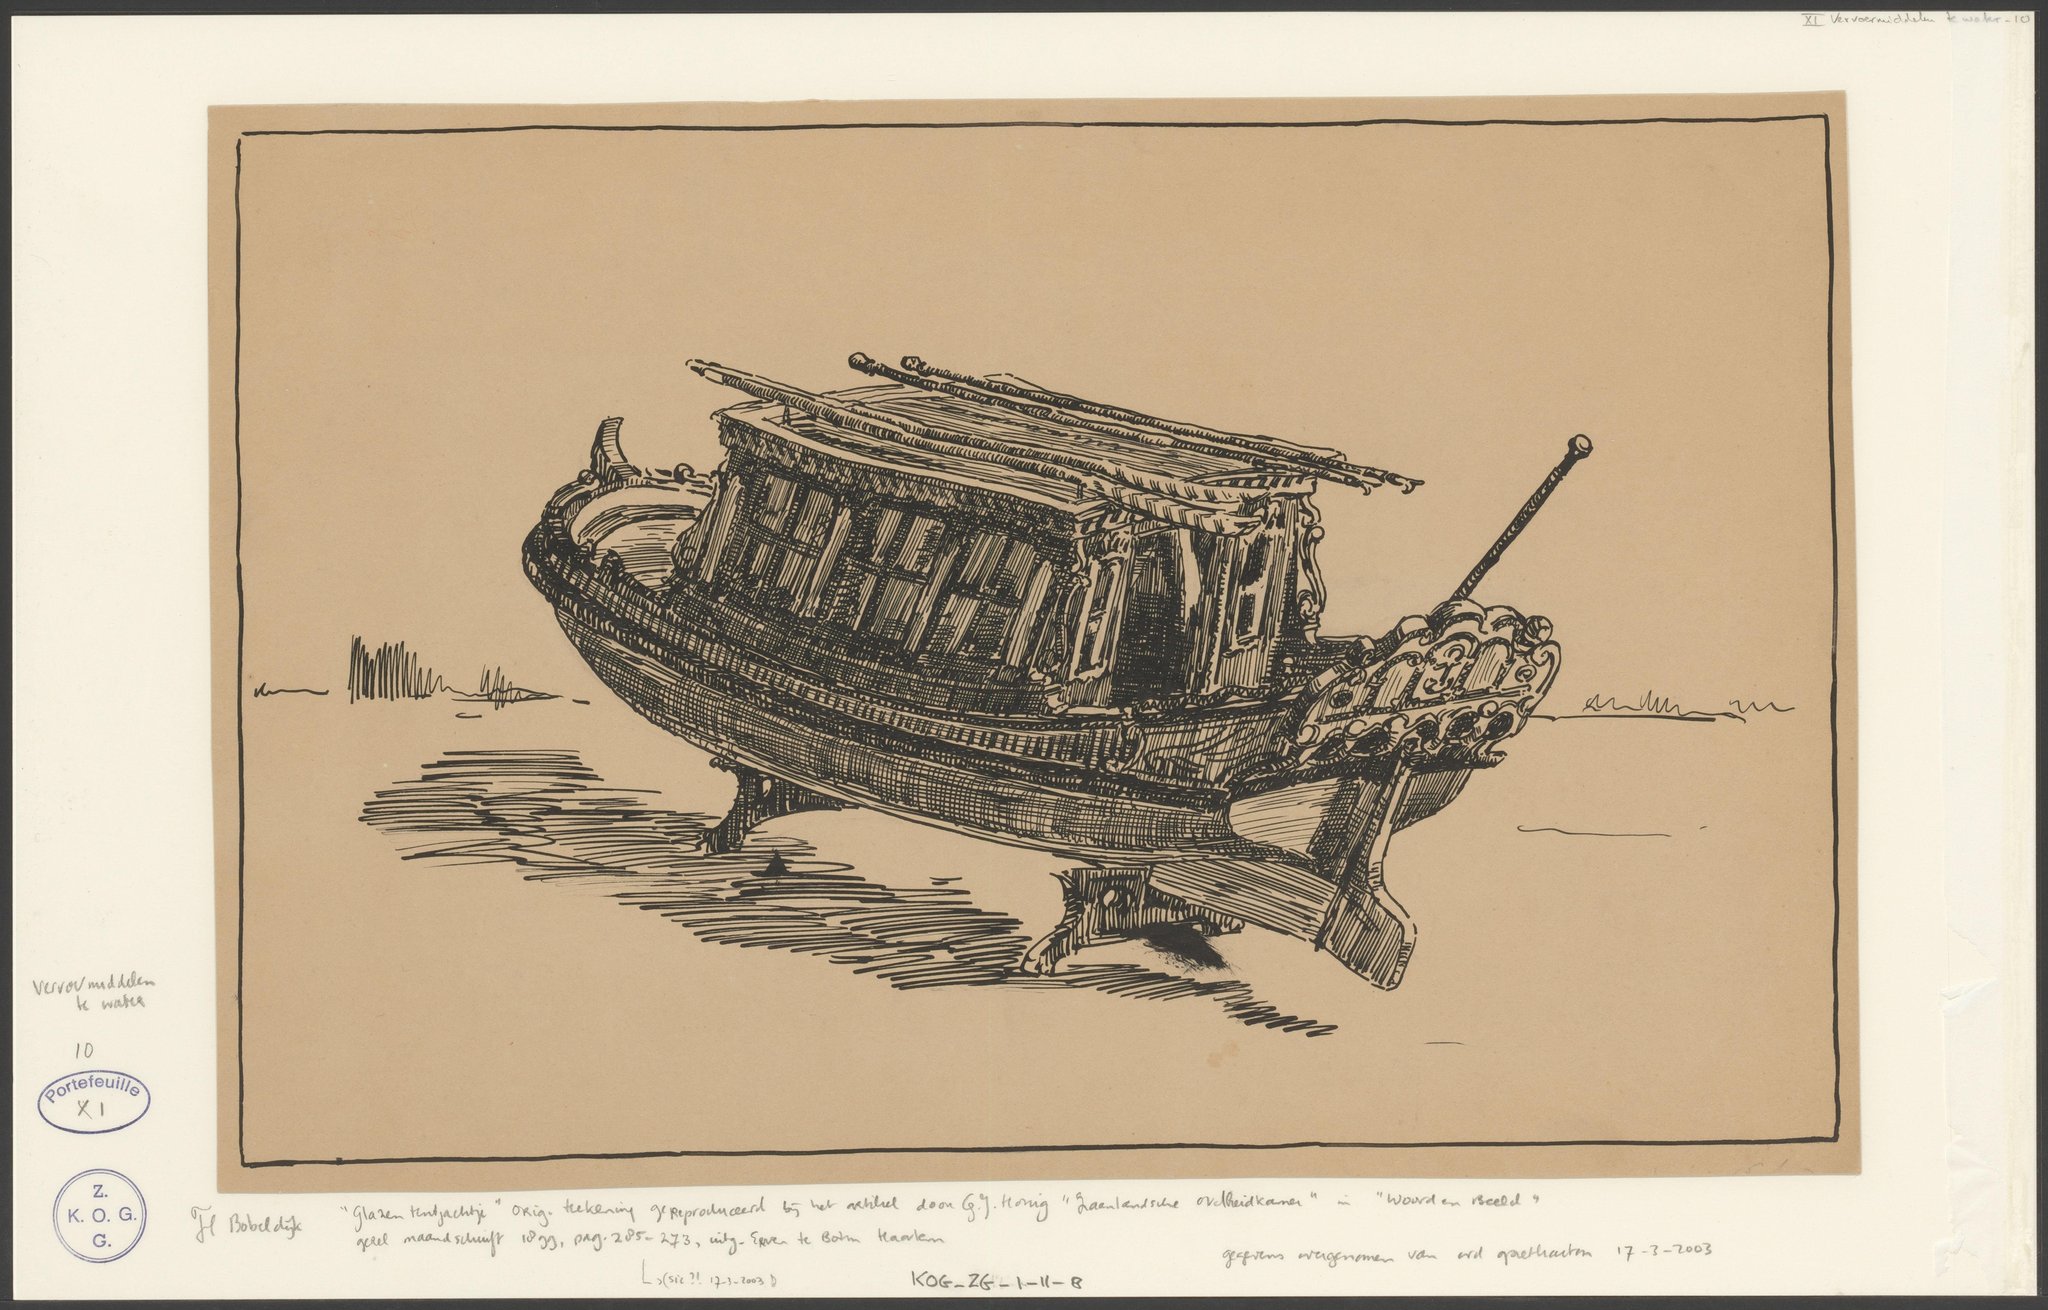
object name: design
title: Tentjacht op het land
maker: felicien bobeldijk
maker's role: draughtsman, print maker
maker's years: 1876-1964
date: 1899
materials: ink, paper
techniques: pen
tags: baby-carriage, pram, perambulator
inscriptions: collector's mark: Lugt 1641, stamp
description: Onderwerpsrubrieken binnen de Atlas Zeden en Gewoonten: Handel, nijverheid en verkeer, Vervoermiddelen te land en te water, Vervoermiddelen te water.